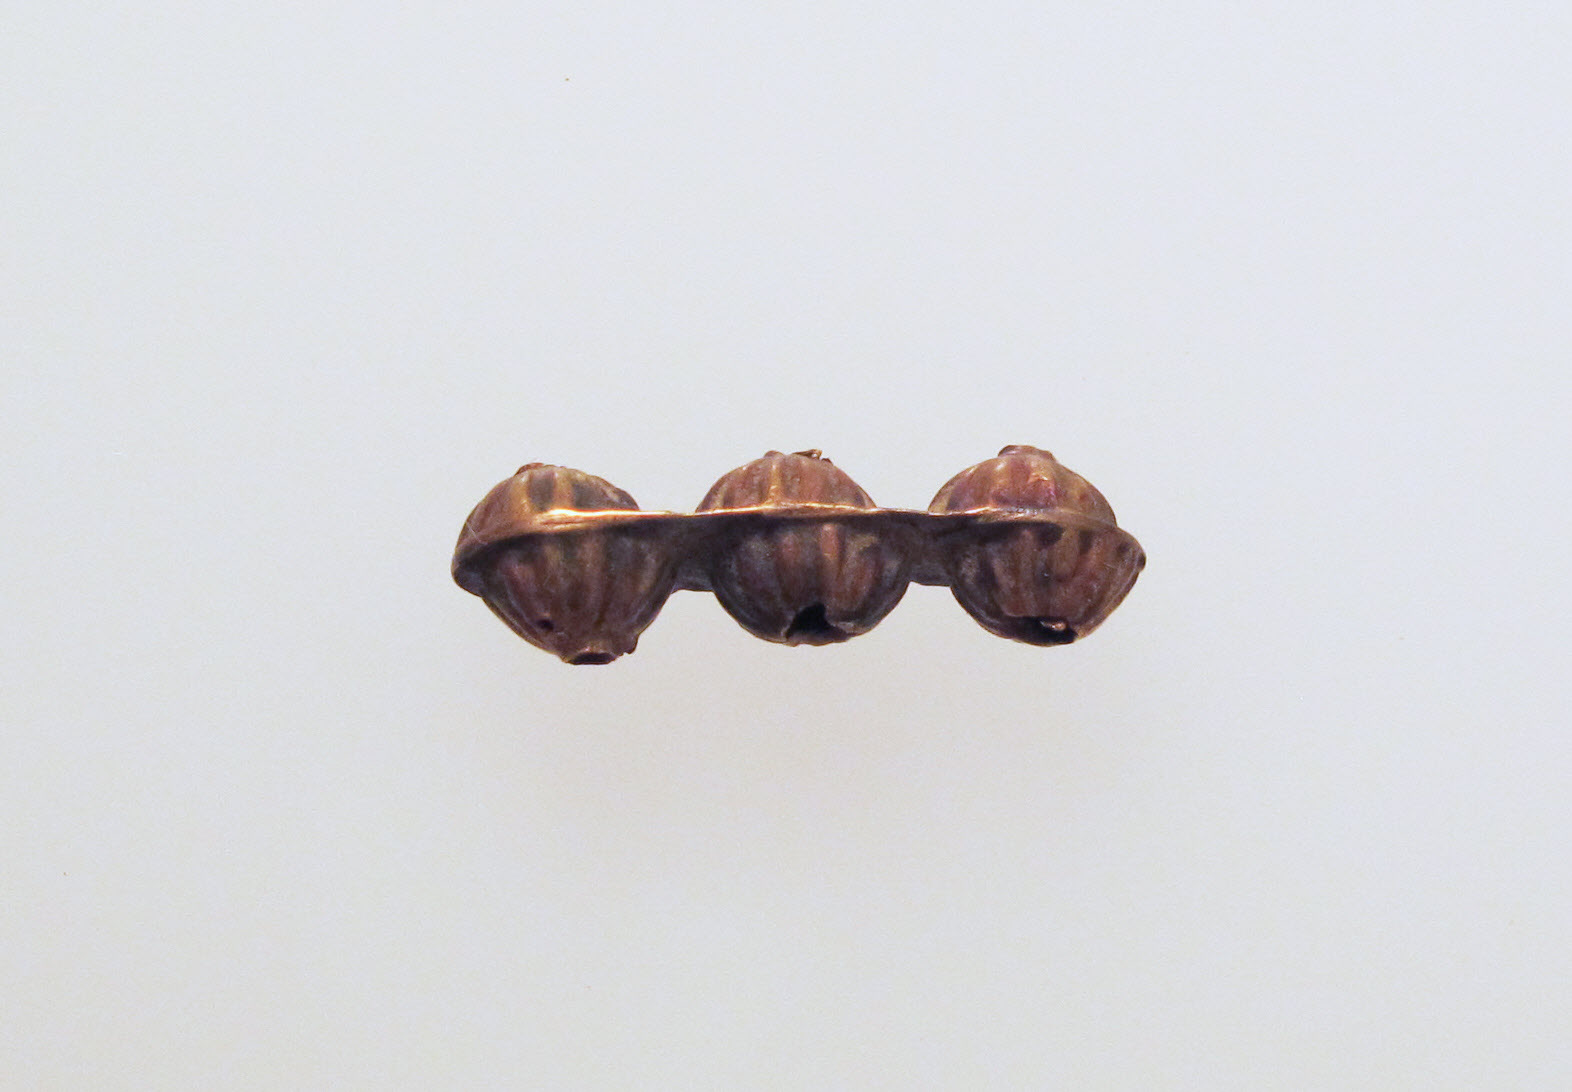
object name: bead, control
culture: cypriot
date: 3900 BCE-100 CE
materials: gold